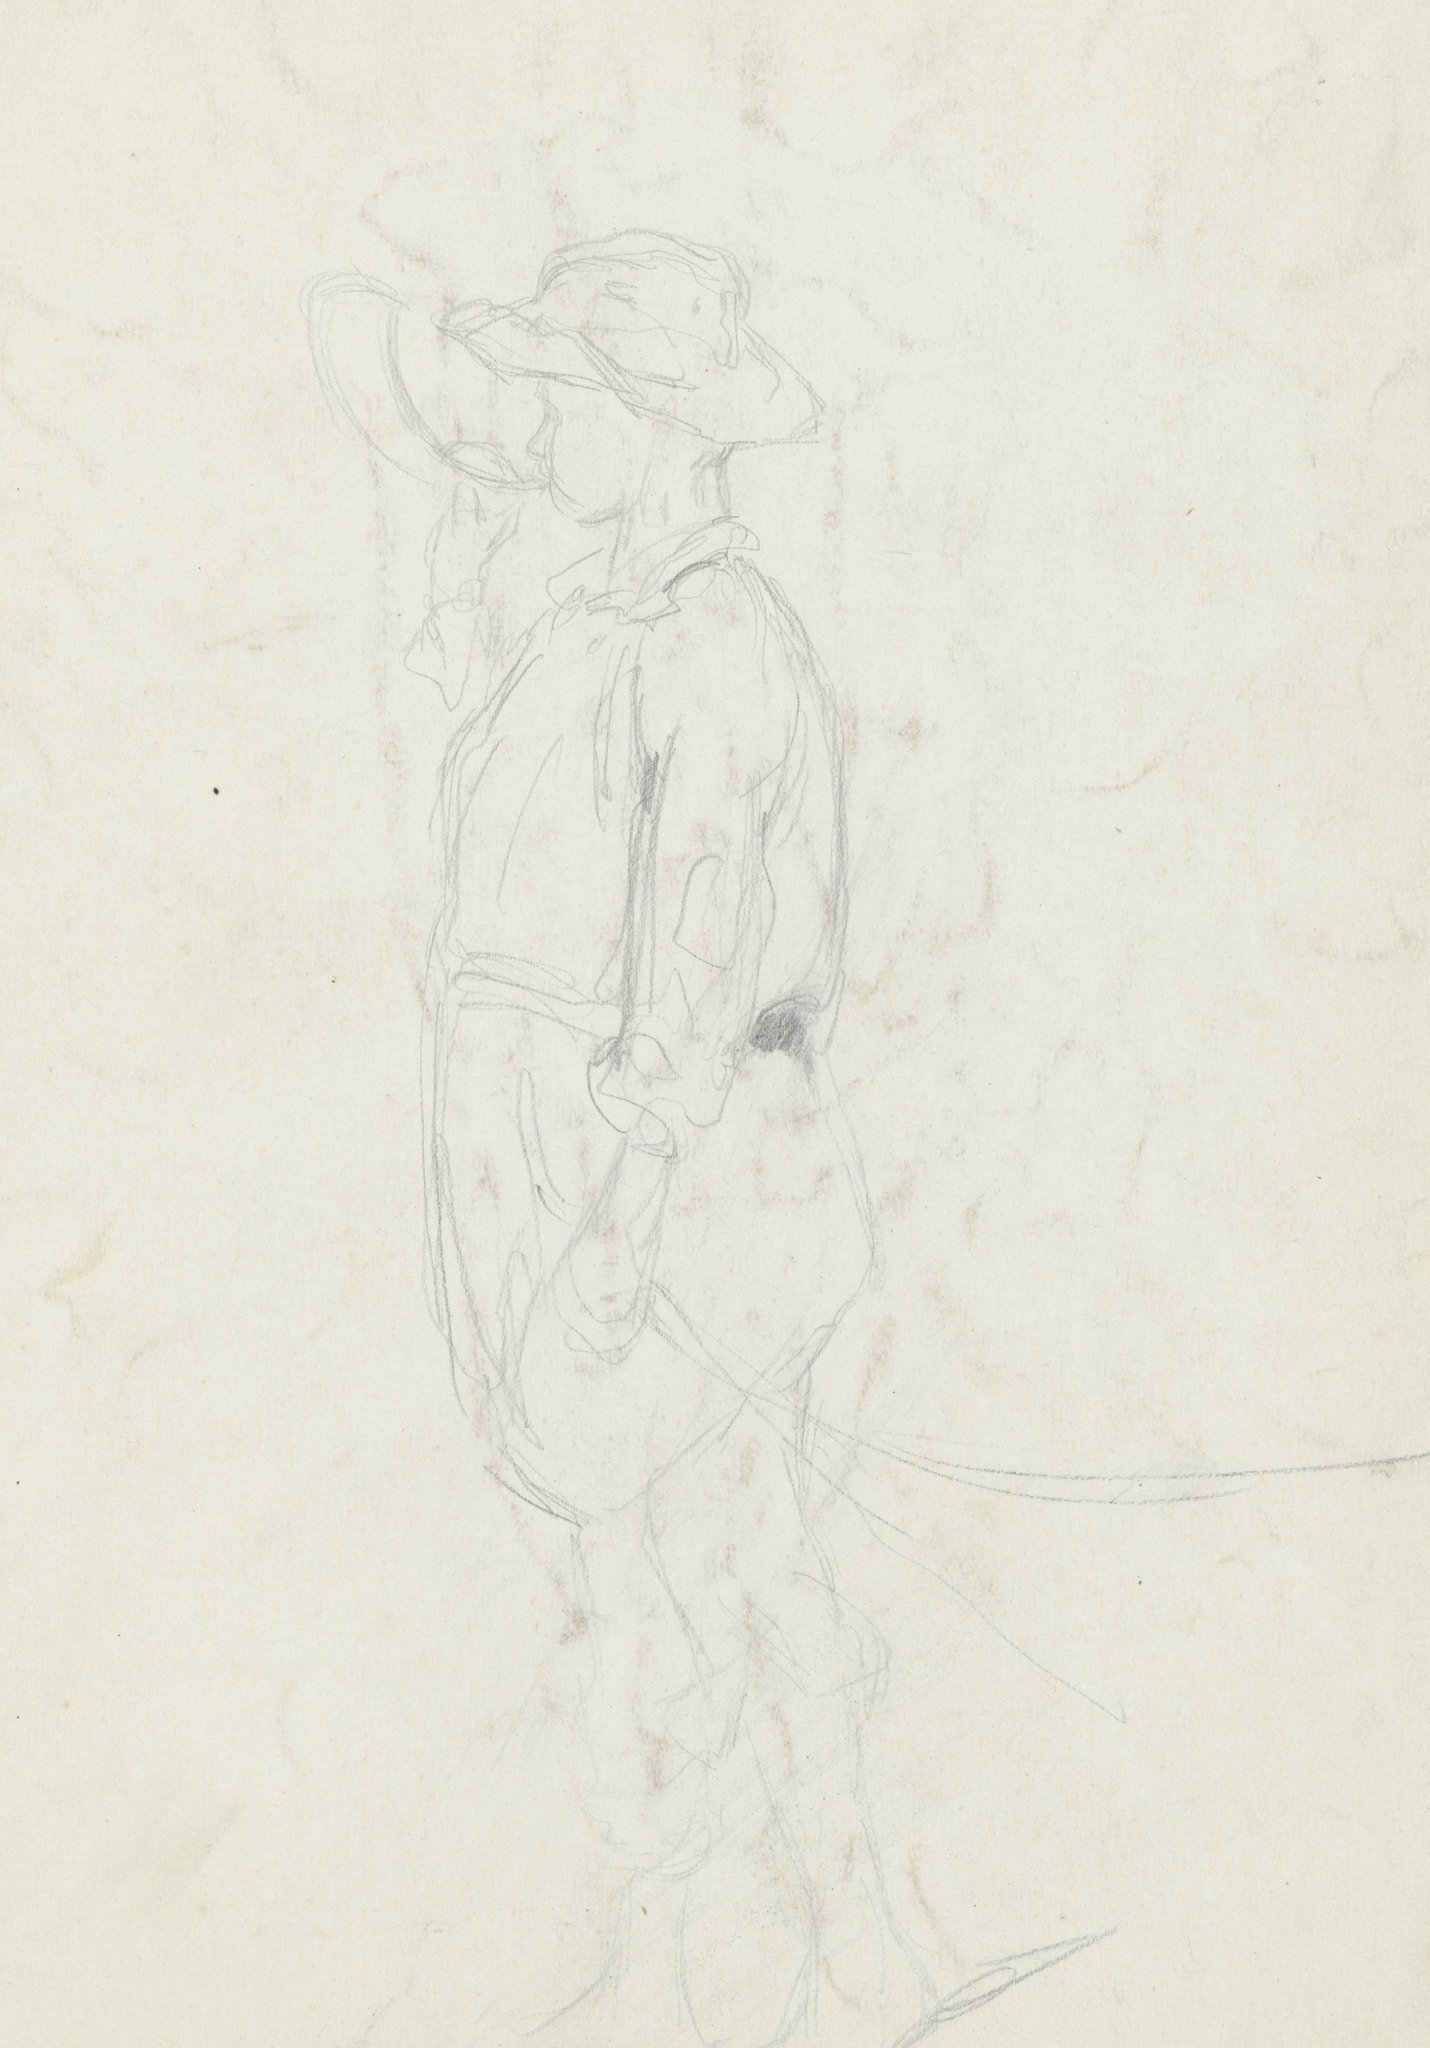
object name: drawing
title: Schets van een jongen die op een hoorn blaast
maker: anton mauve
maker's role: draughtsman, painter, print maker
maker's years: 1838-1888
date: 1848-1888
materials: paper, pencil